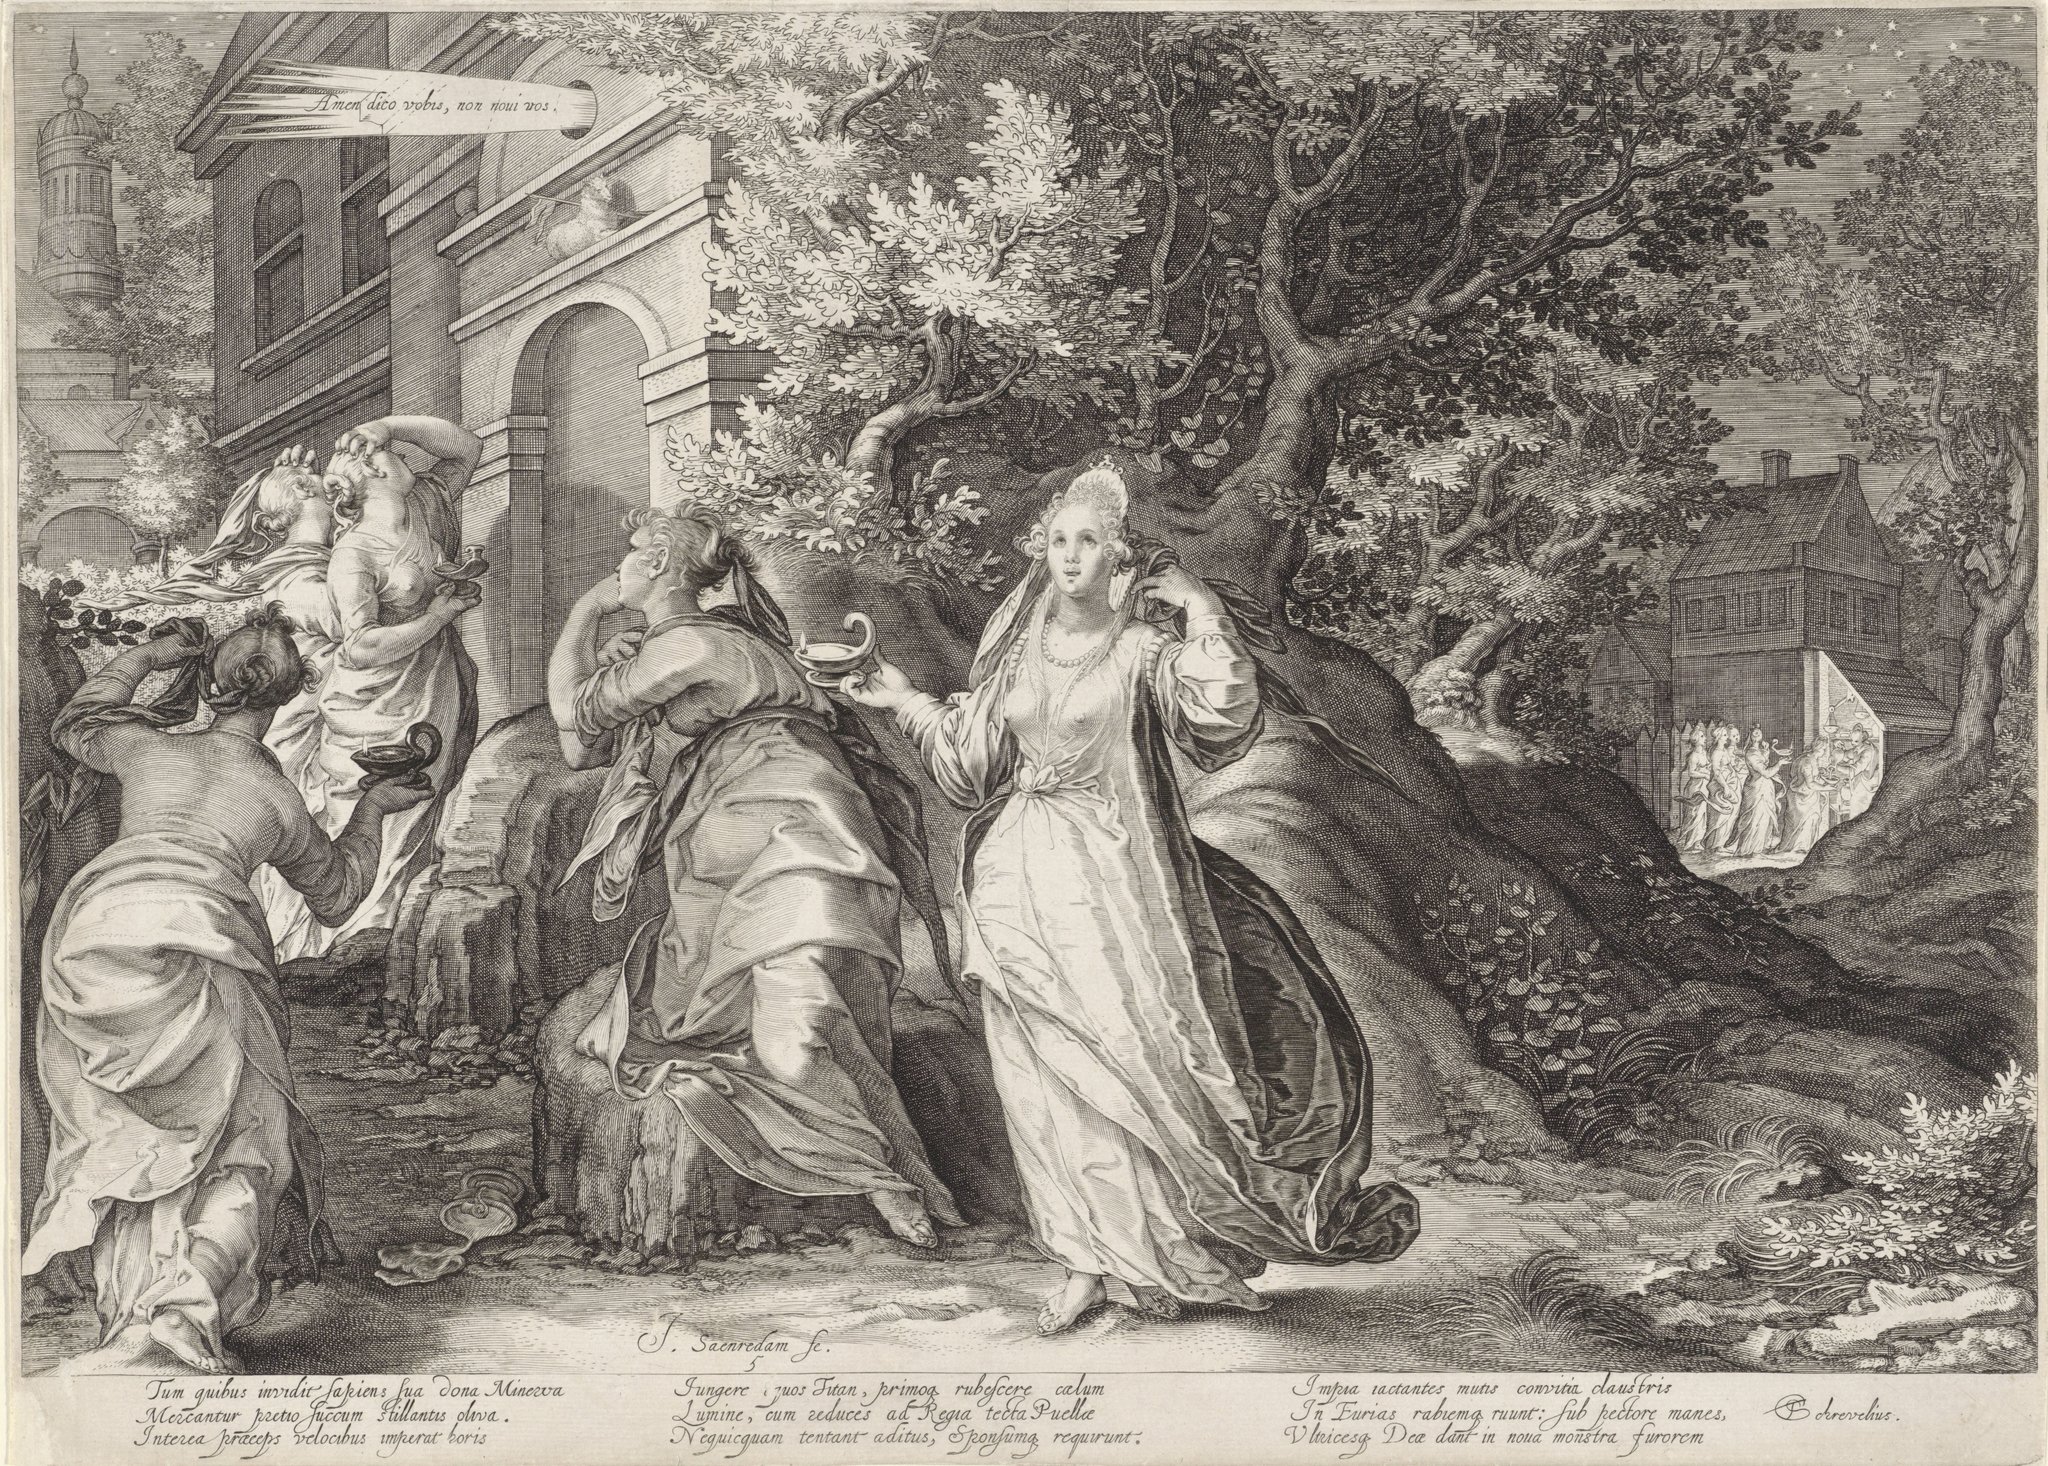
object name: print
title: Vijf dwaze maagden worden niet ontvangen door de bruidegom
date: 1606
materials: paper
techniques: engraving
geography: assendelft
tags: the wise virgins are let into the house with the bridegroom (christ); the foolish virgins are shut out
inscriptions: collector's mark: Lugt 240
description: De vijf dwaze maagden voor de toegangspoort van het huis van de bruidegom. Ze worden niet toegelaten. Boven de toegangspoort het Lam Gods. Op de achtergrond vullen de vijf dwaze maagden hun olielampen bij een marktkramer. De prent heeft een Latijns onderschrift.